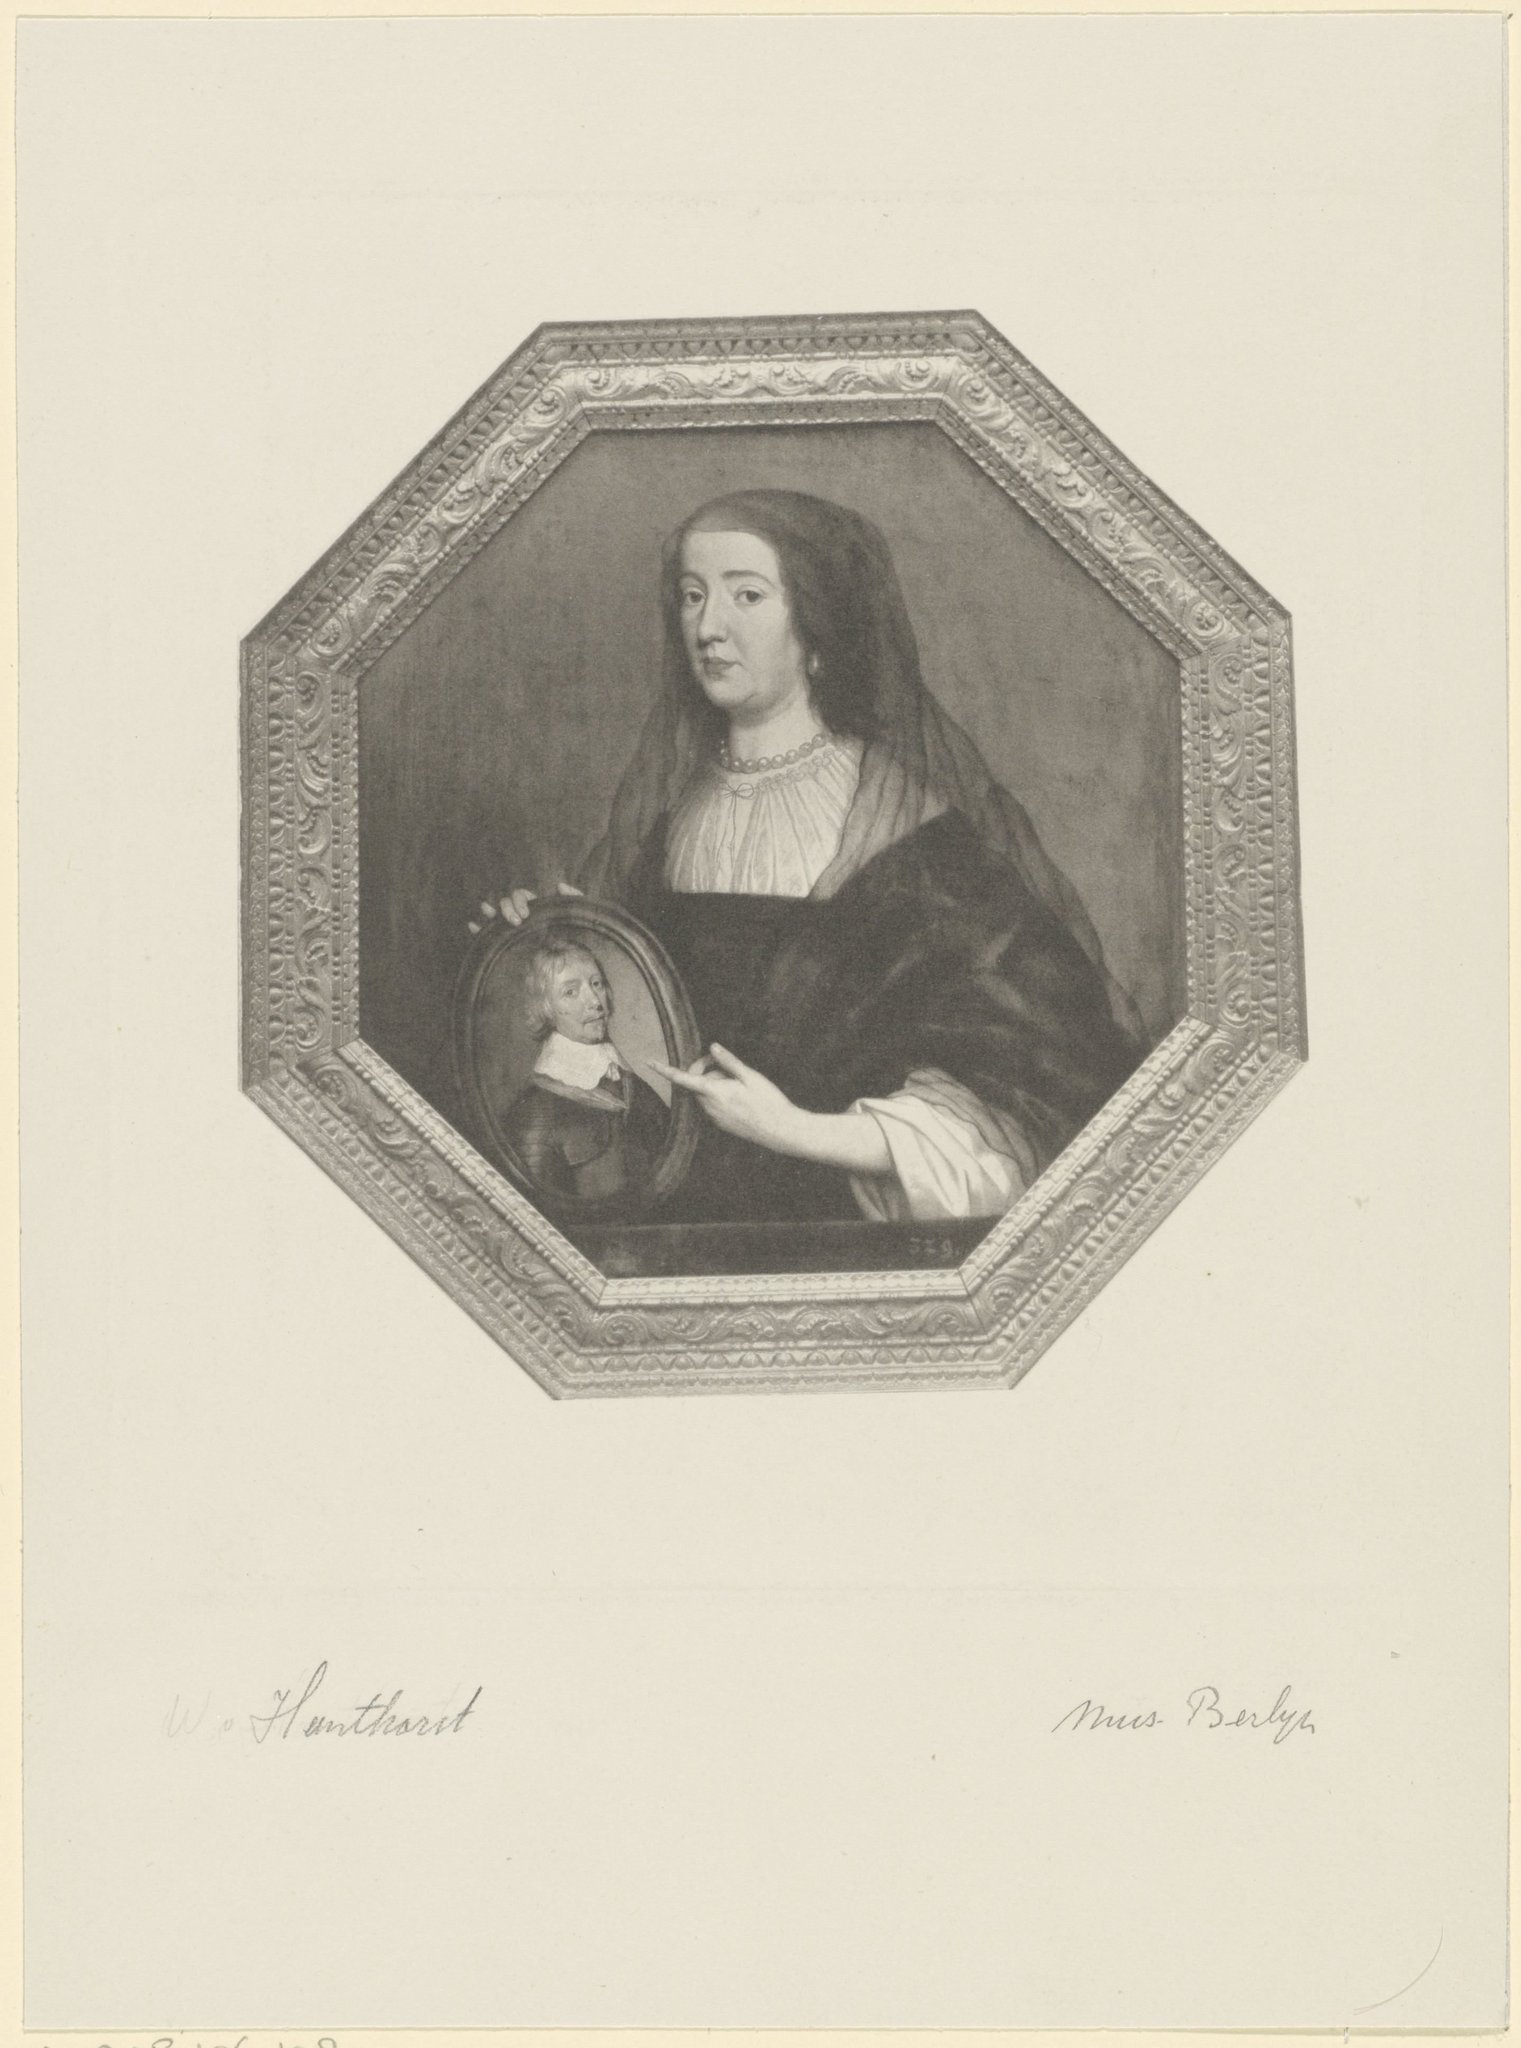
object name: photomechanical print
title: Portret van Amalia van Solms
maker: Anonymous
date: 1850-1949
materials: paper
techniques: photograph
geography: netherlands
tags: the hague, amalia of solms-braunfels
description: Portret van Amalia in een een achtkantige omlijsting. In haar handen een portret van Frederik Hendrik in een ovaal.